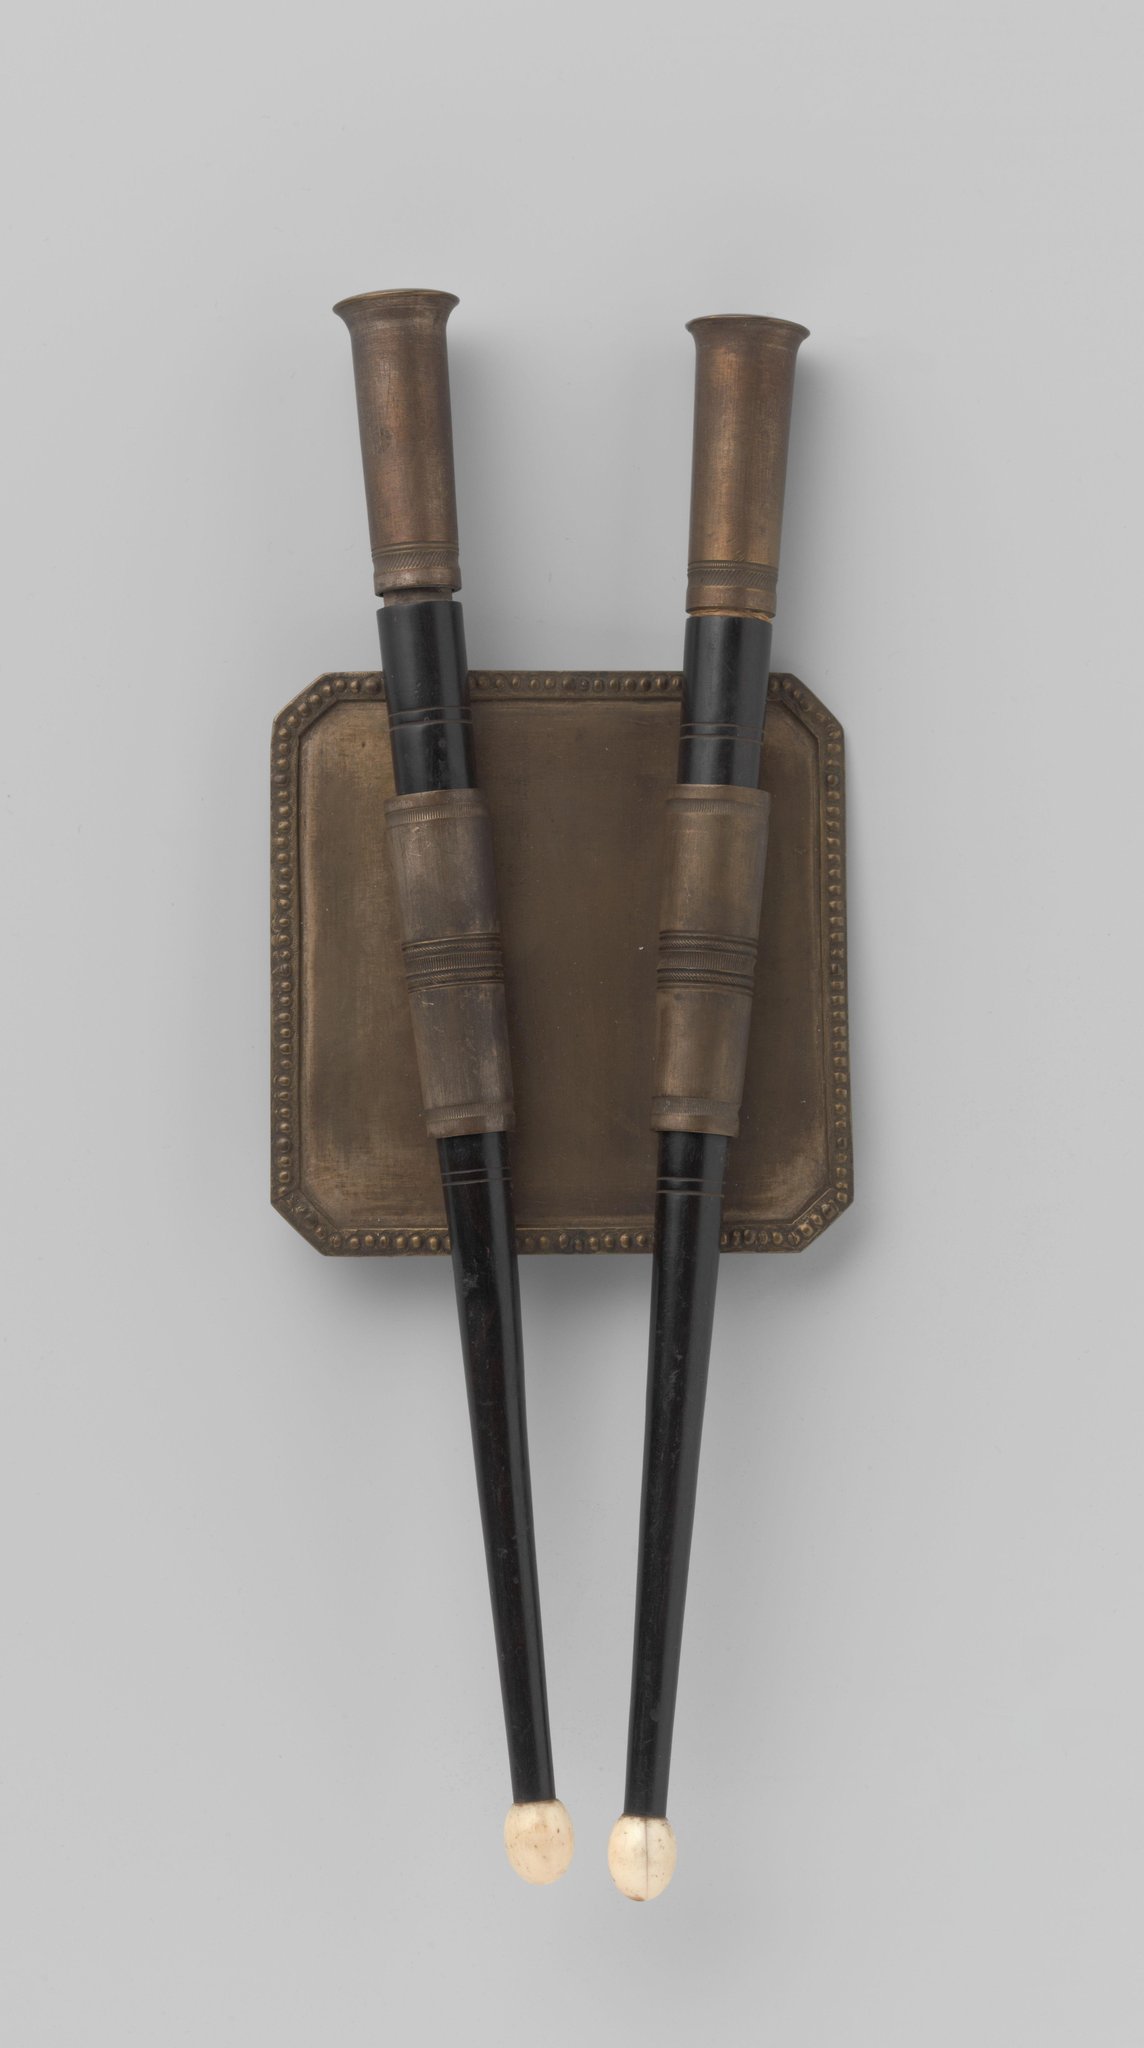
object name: stick plate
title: Drumsticks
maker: Anonymous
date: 1817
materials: wood, ivory, plate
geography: netherlands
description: Ebbenhouten tromstok voor tamboer-majoor met ivoren knop. Stok bezet met bussen van pleet.